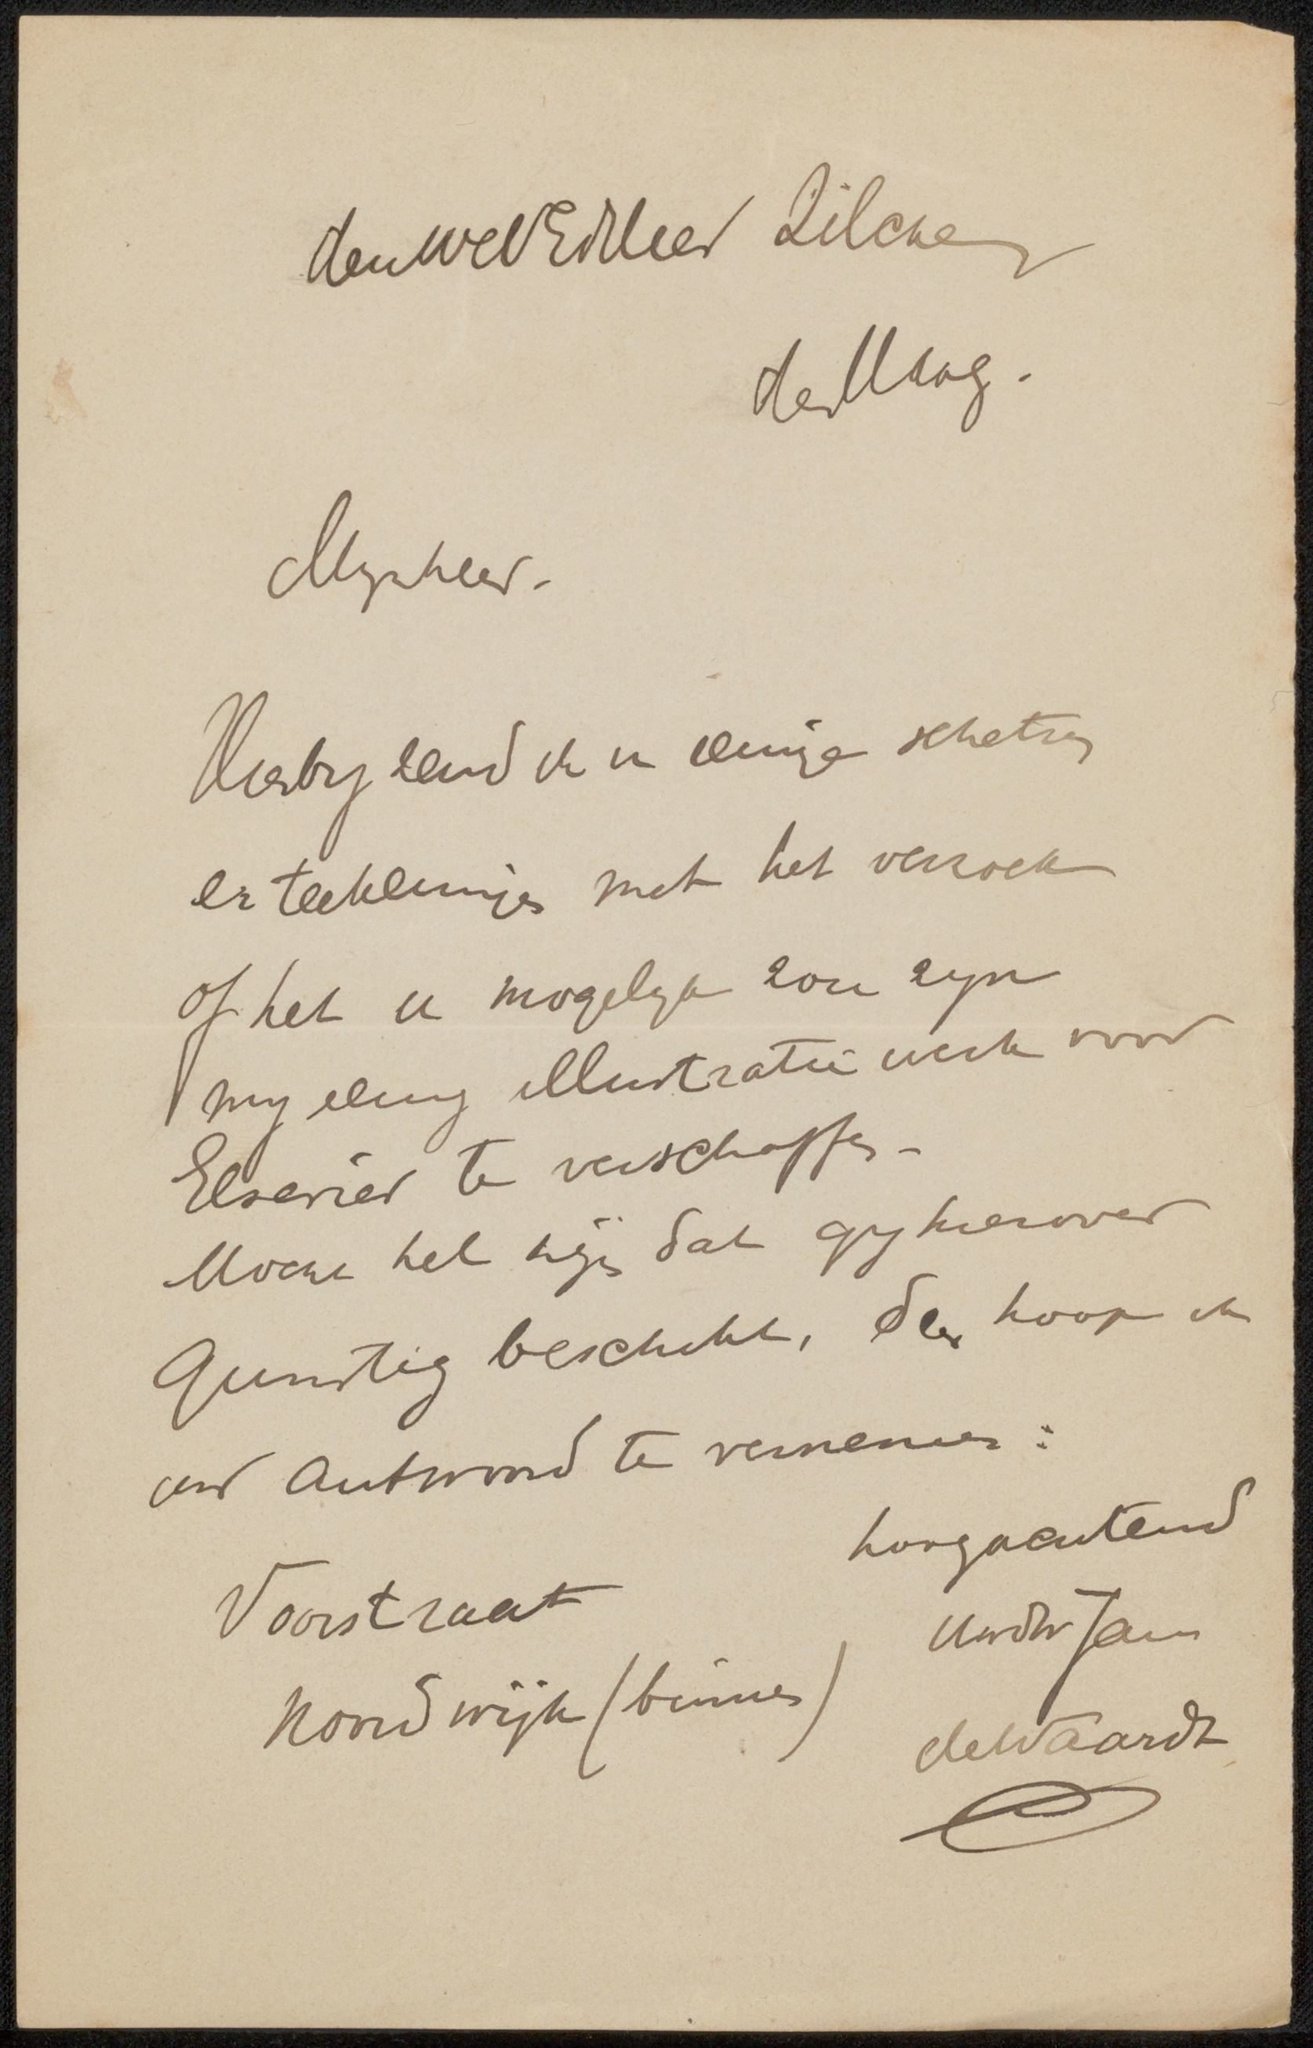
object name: letter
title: Brief aan Philip Zilcken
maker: jan de waardt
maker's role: draughtsman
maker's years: 1871-1909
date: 1881-1909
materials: ink, paper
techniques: pen, writing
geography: noordwijk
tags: the hague, painter, draughtsman, philip zilcken, drawing, illustration ~ printed matter, book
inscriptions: collector's mark: ‘RPK’